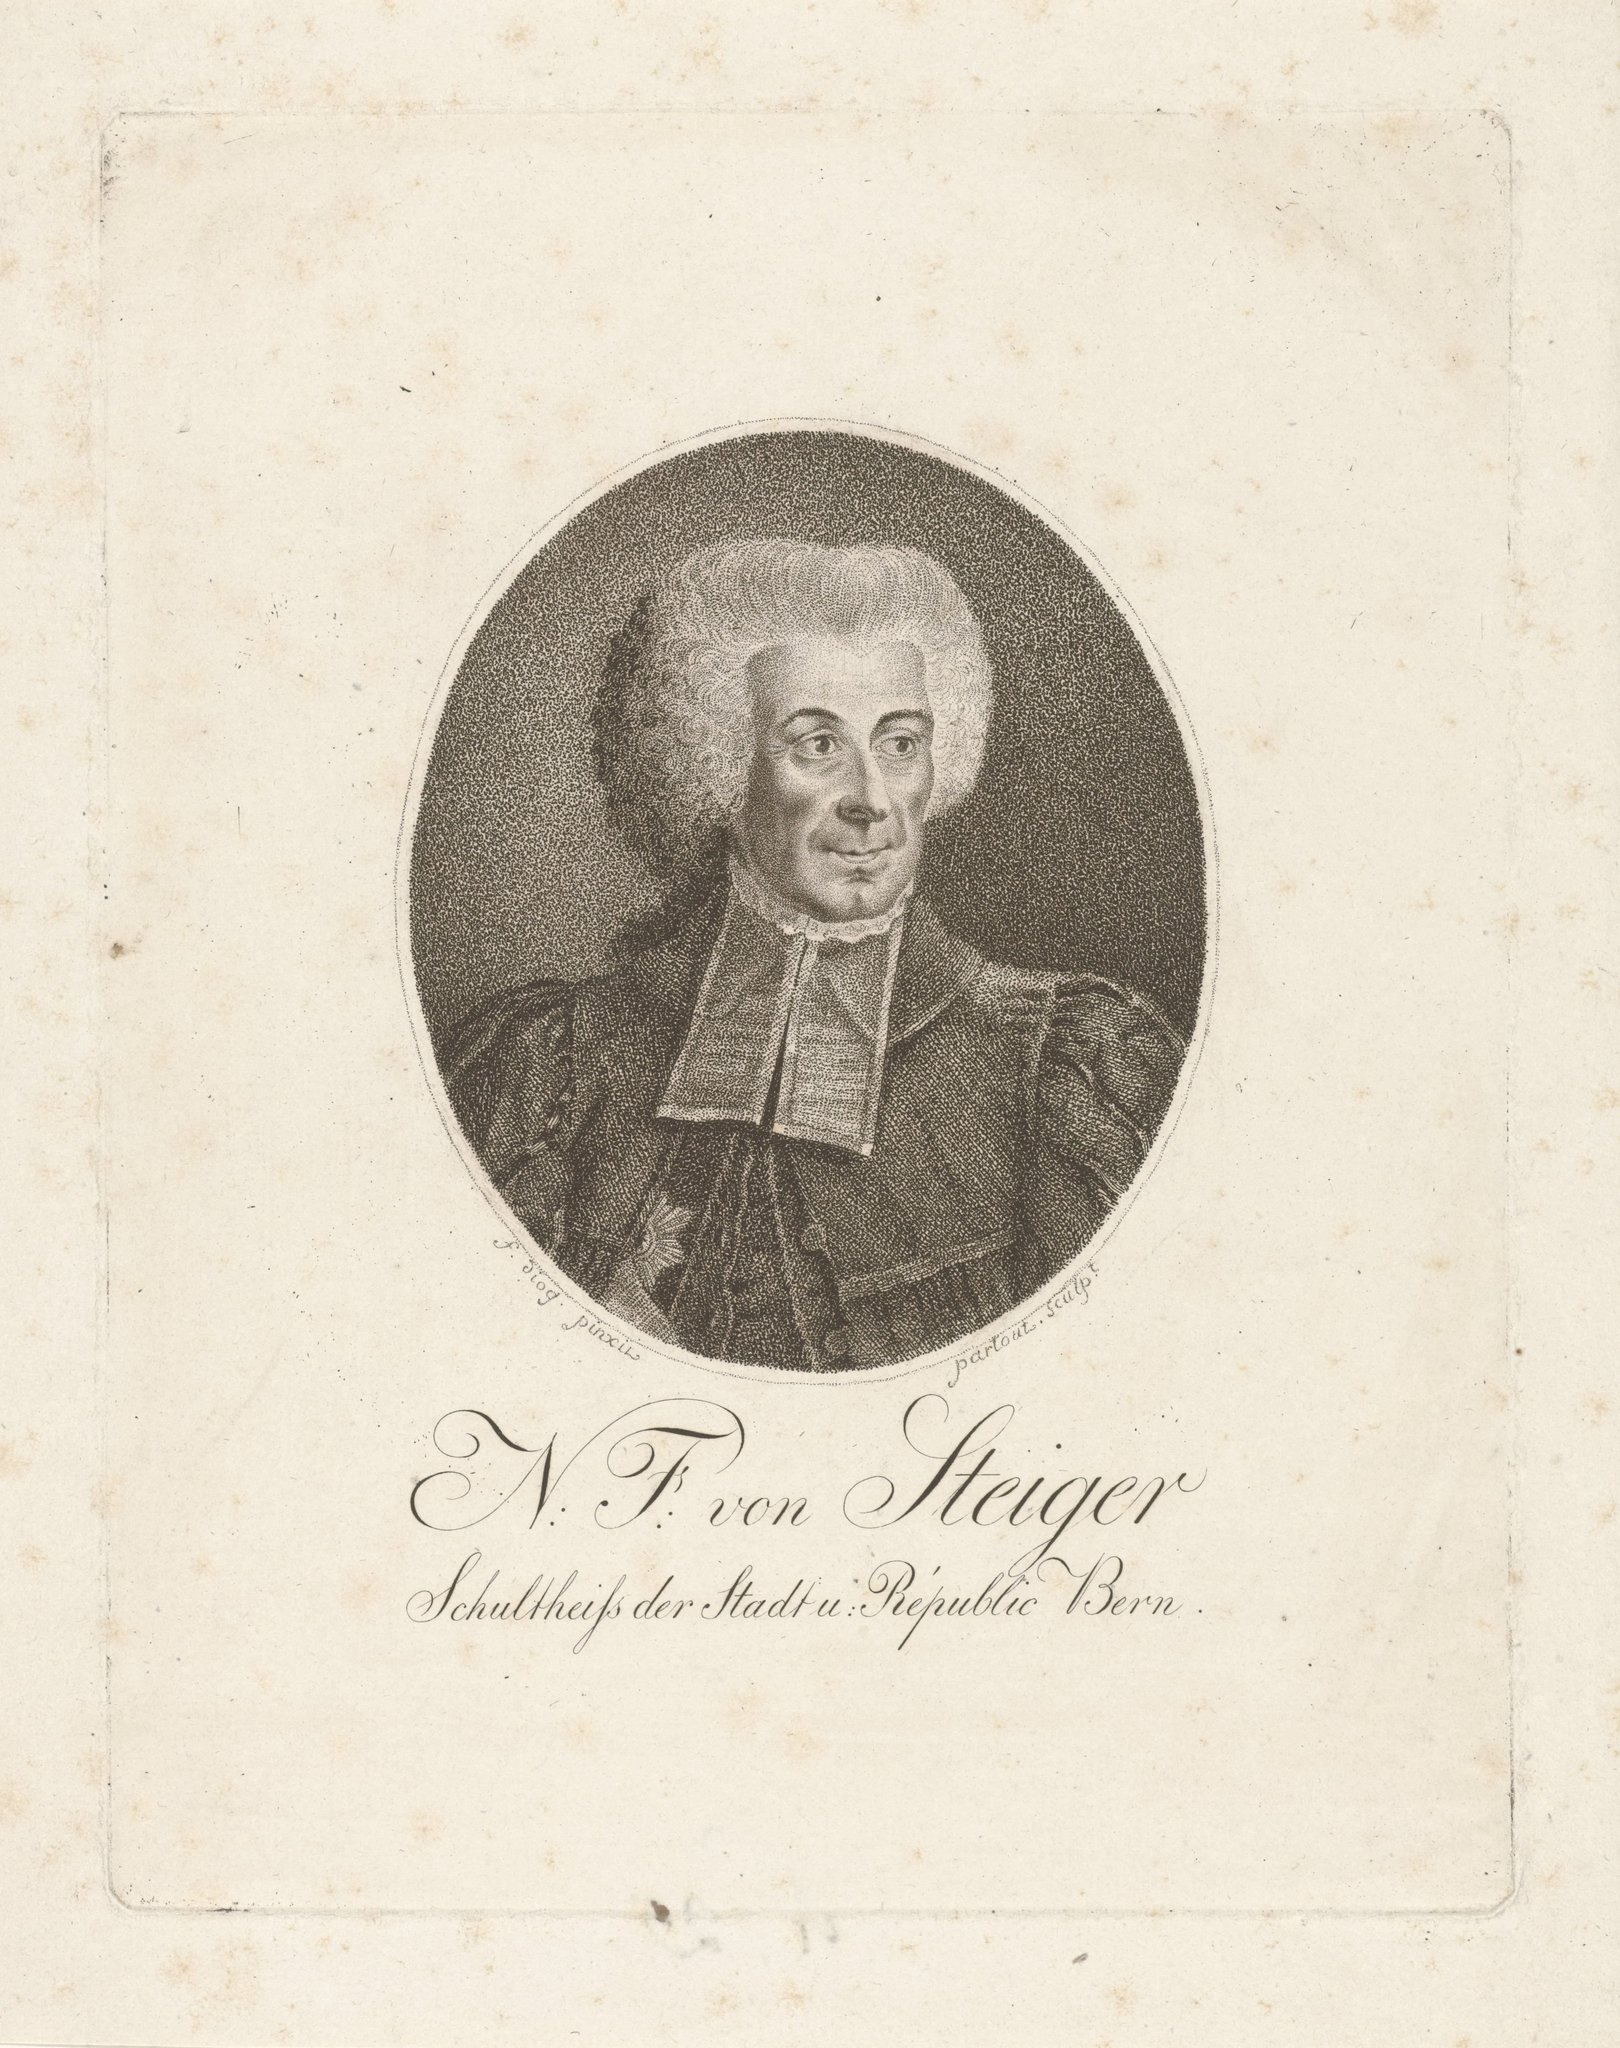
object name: print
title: Portret van N.F. von Steiger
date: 1769-1789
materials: paper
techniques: etching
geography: zeeland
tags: augsburg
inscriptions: collector's mark: Lugt 2228, inscription: ‘N 125’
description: Busteportret van N.F. von Steiger, in toga. Het portret is gevat in een ovale omlijsting. In de marge de naam en functie van geportretteerde.